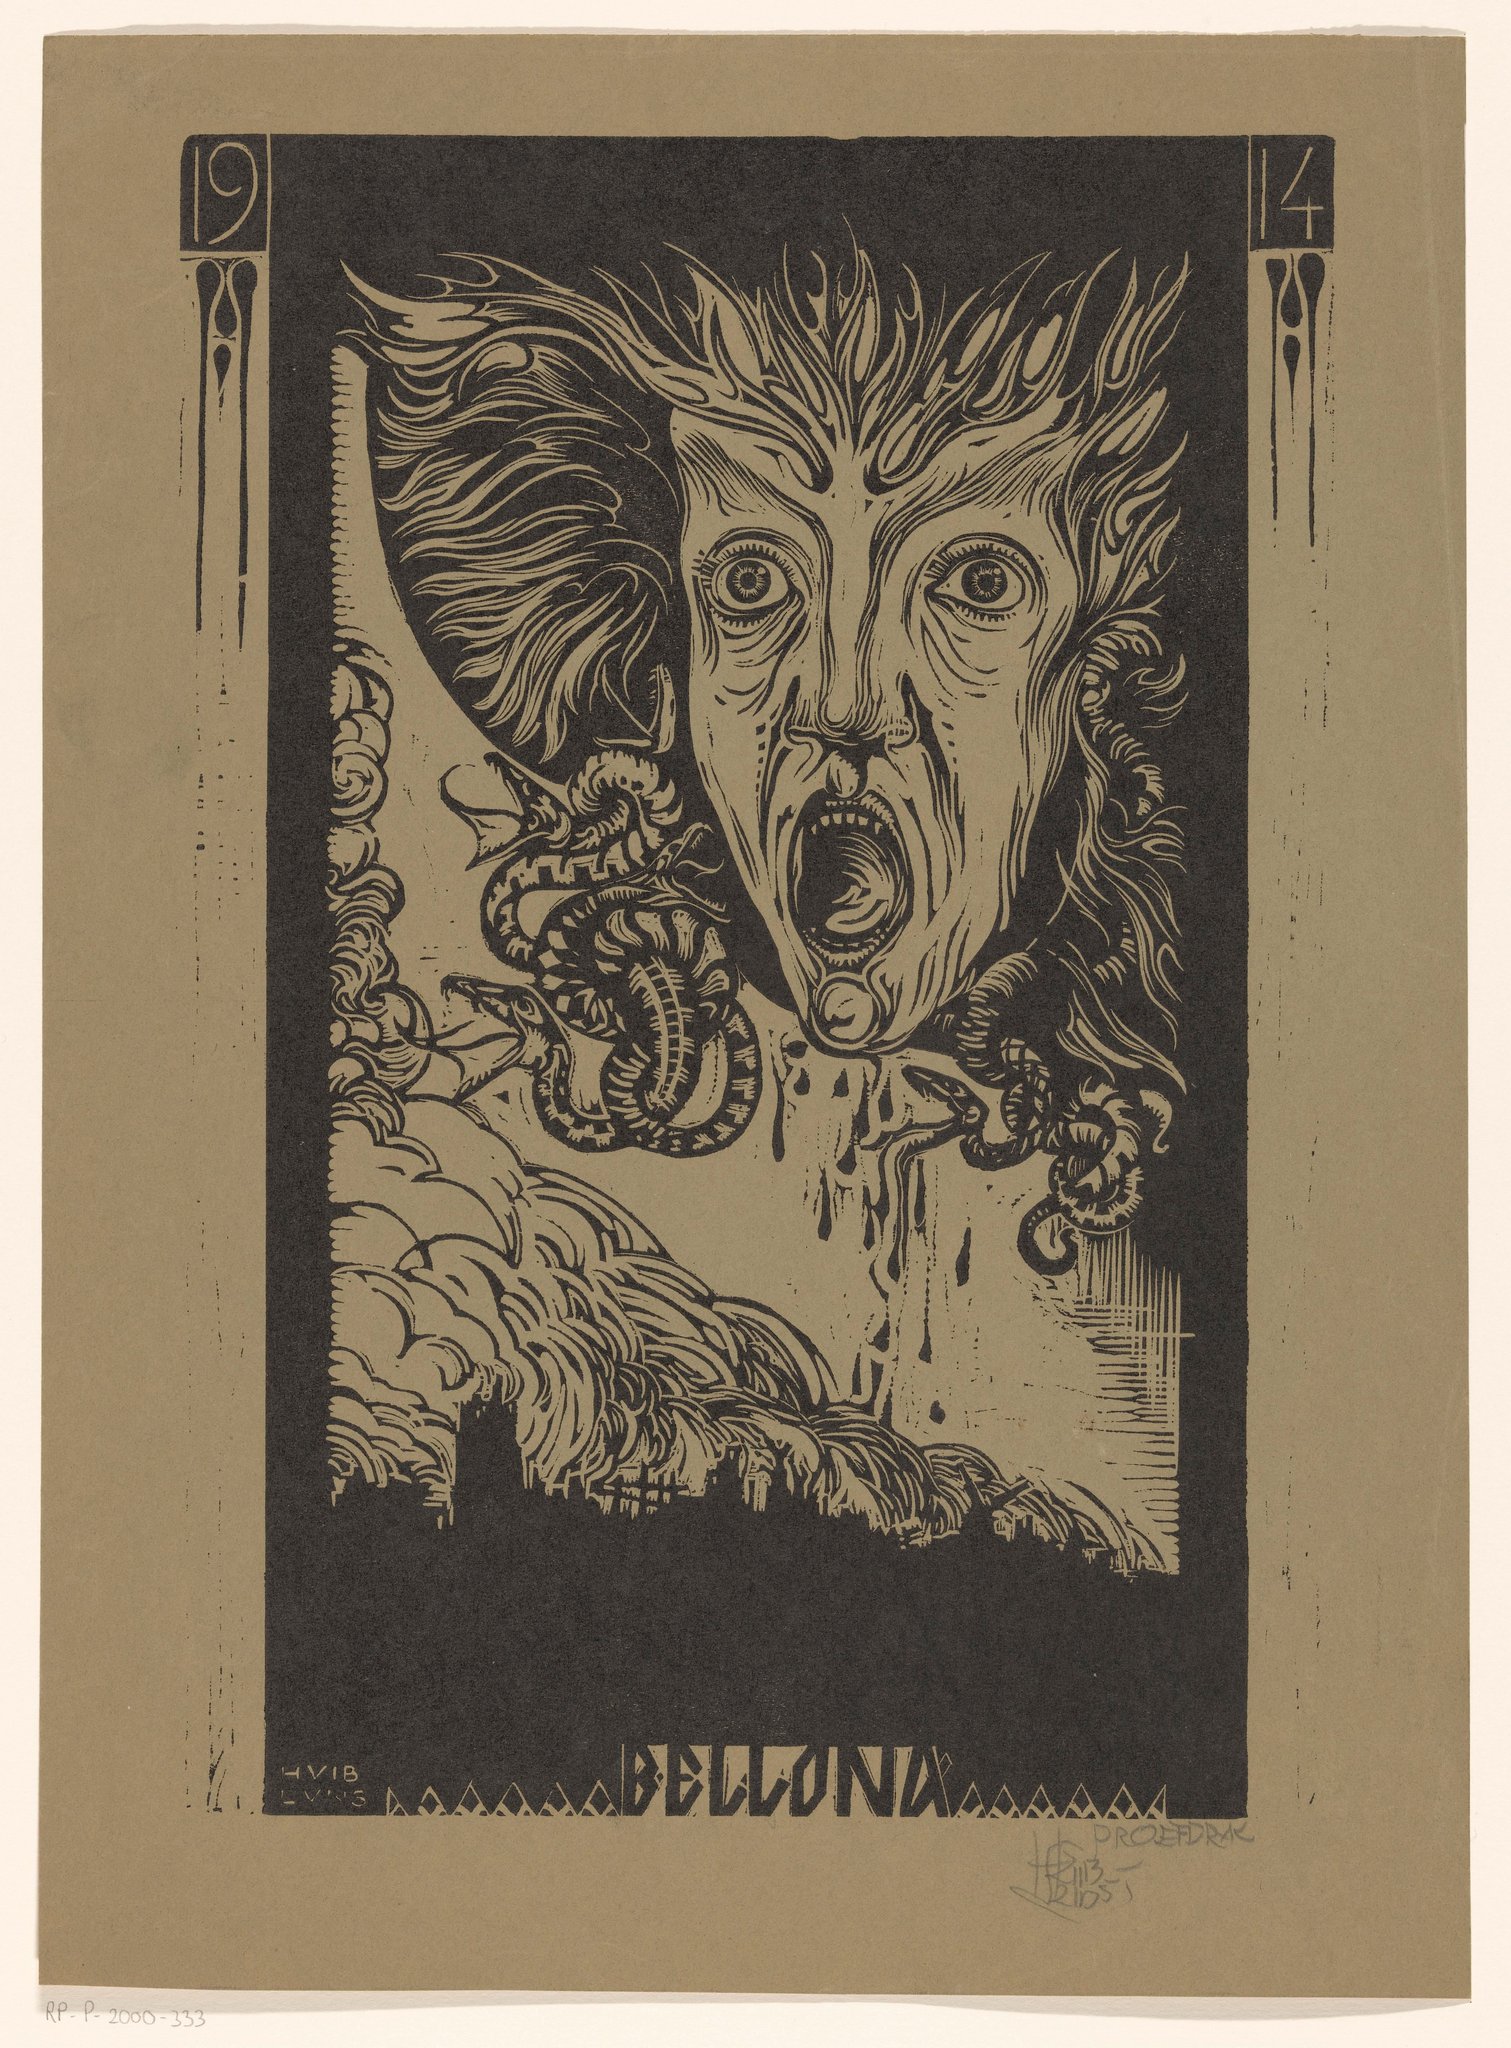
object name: print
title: Bellona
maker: huib luns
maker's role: draughtsman, print maker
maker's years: 1881-1942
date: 1914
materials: paper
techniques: woodcut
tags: bellona (enyo), prospect of city, town panorama, silhouette of city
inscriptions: collector's mark: Lugt 2228, collector's mark: Lugt 2760, collector's mark: ‘Ph. J.’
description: Het bovenste gedeelte van de prent is onder de titel 'Oorlog' gebruikt voor: Wendingen. Maandblad voor bouwen en sieren van "Architectura et Amicitia". Amsterdam: De Hooge Brug 1919. 7/8, p. 25.